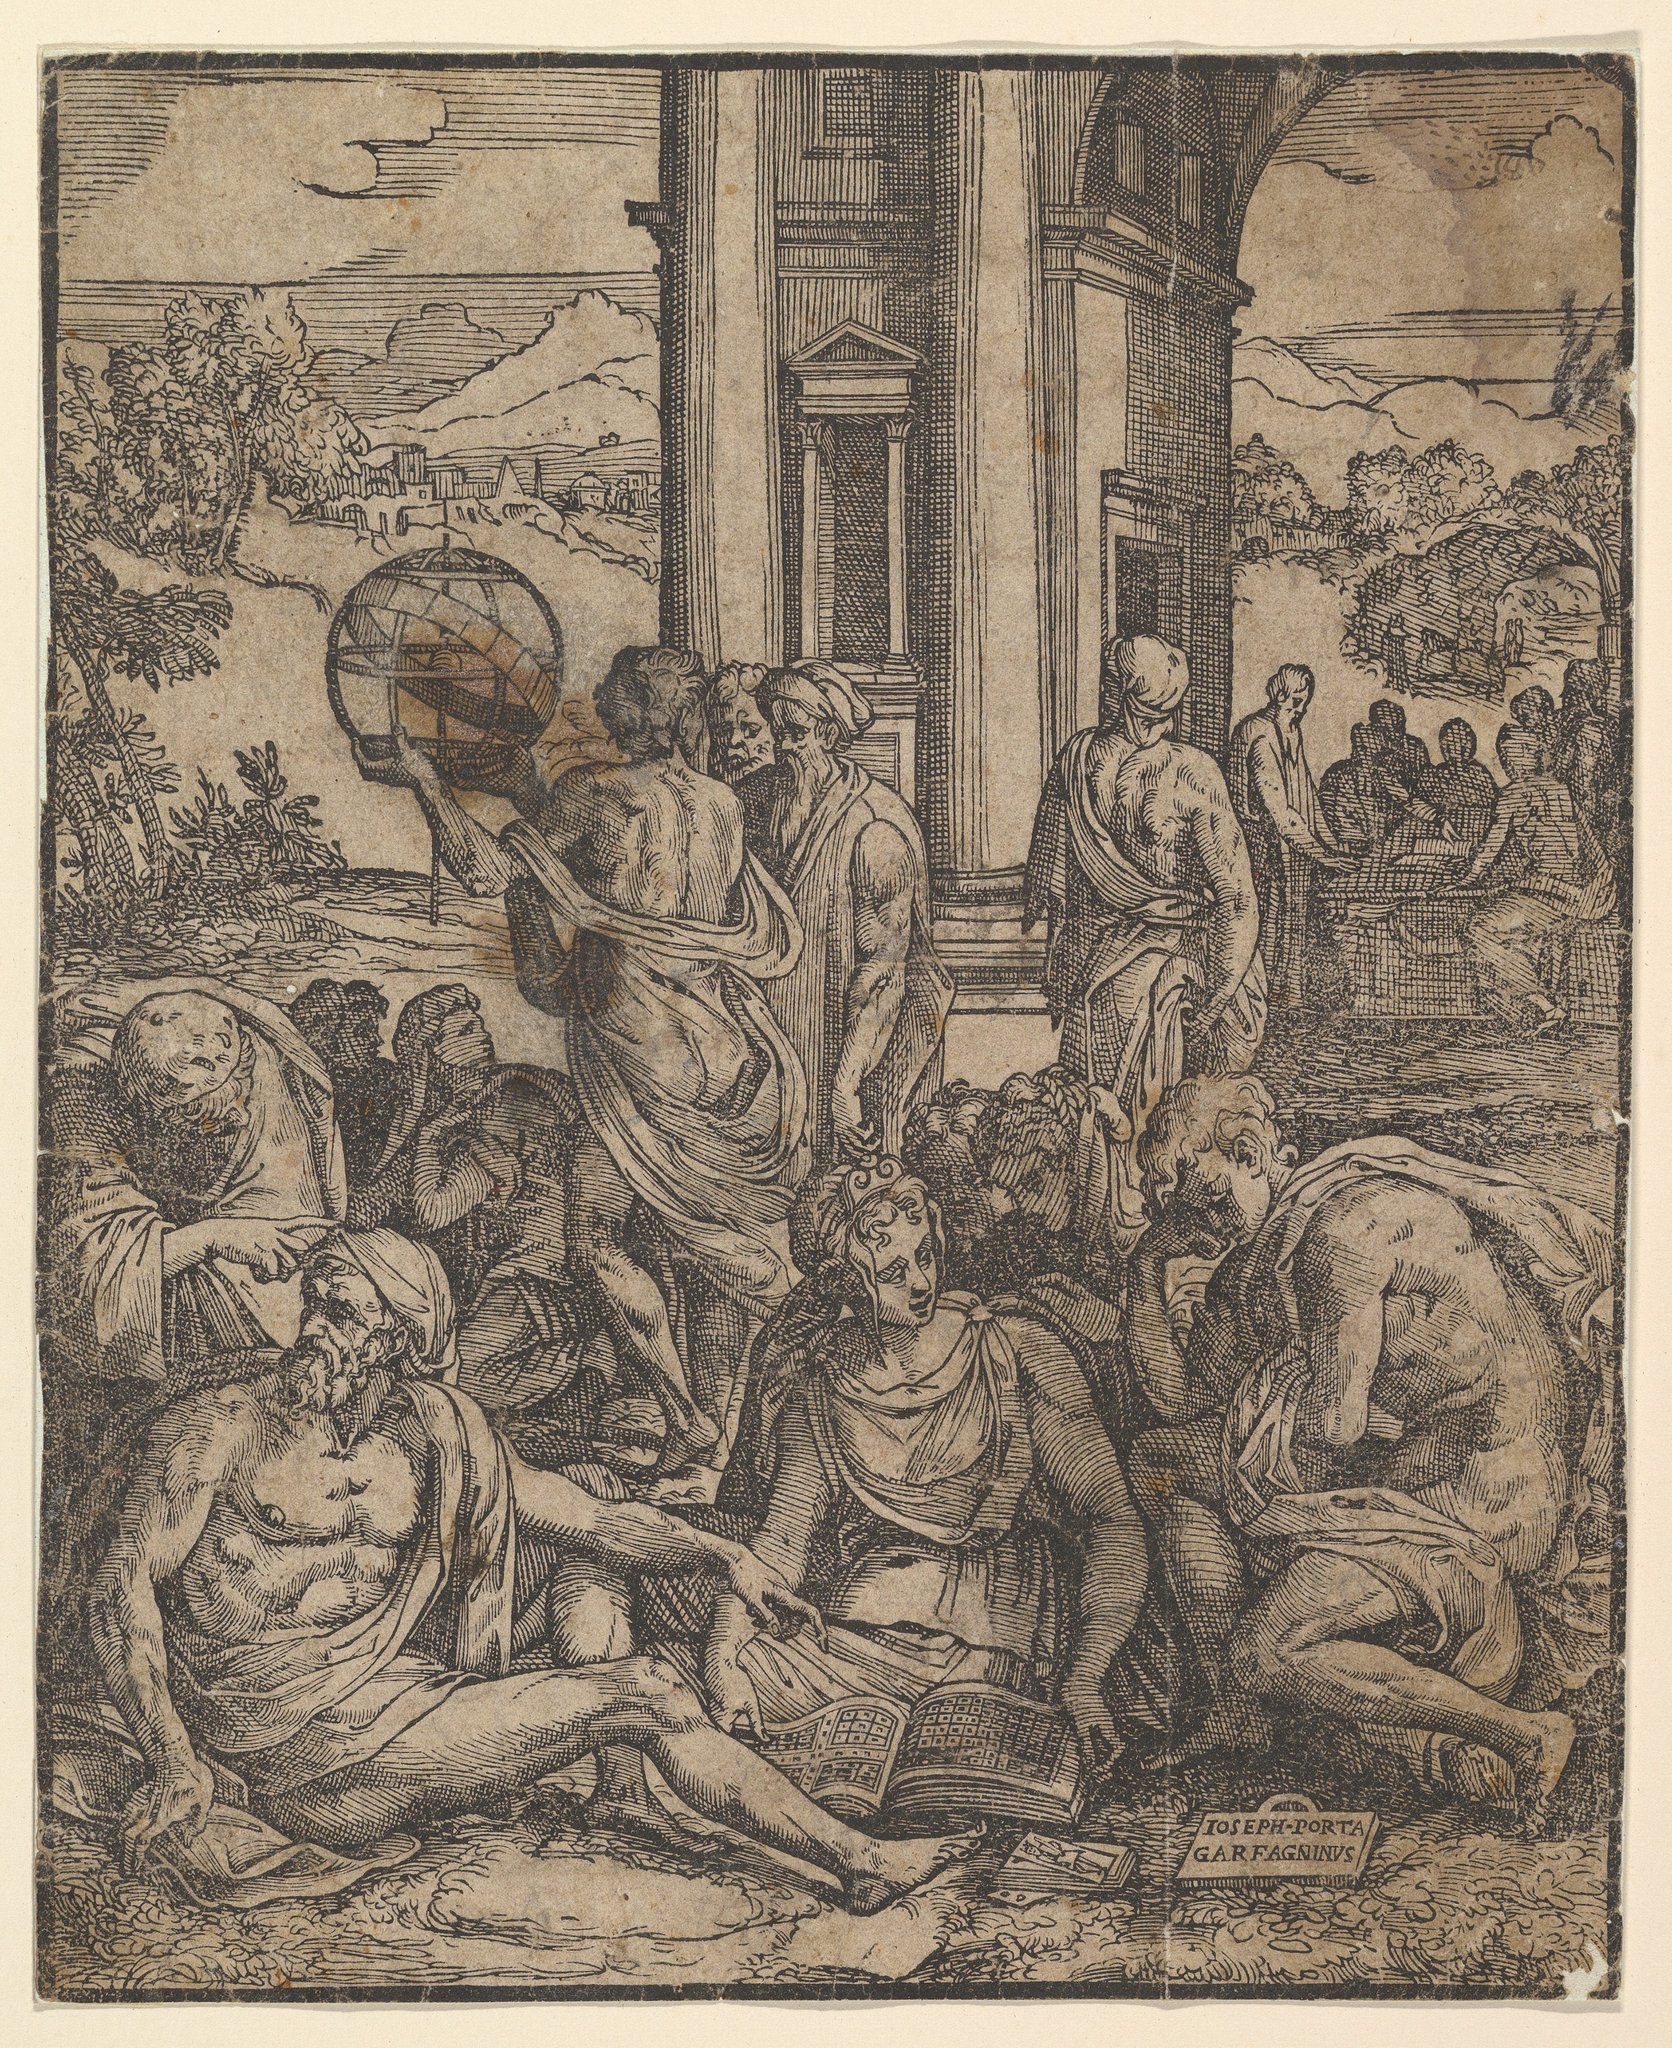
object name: print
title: Frontispiece to "Le sorti di Francesco Marcolini da Forli intitolato Giardino di Pensieri"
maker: giuseppe salviati (giuseppe porta, called il salviati)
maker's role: artist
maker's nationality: italian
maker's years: 1515-1580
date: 1540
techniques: woodcut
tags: books,buildings,men,women